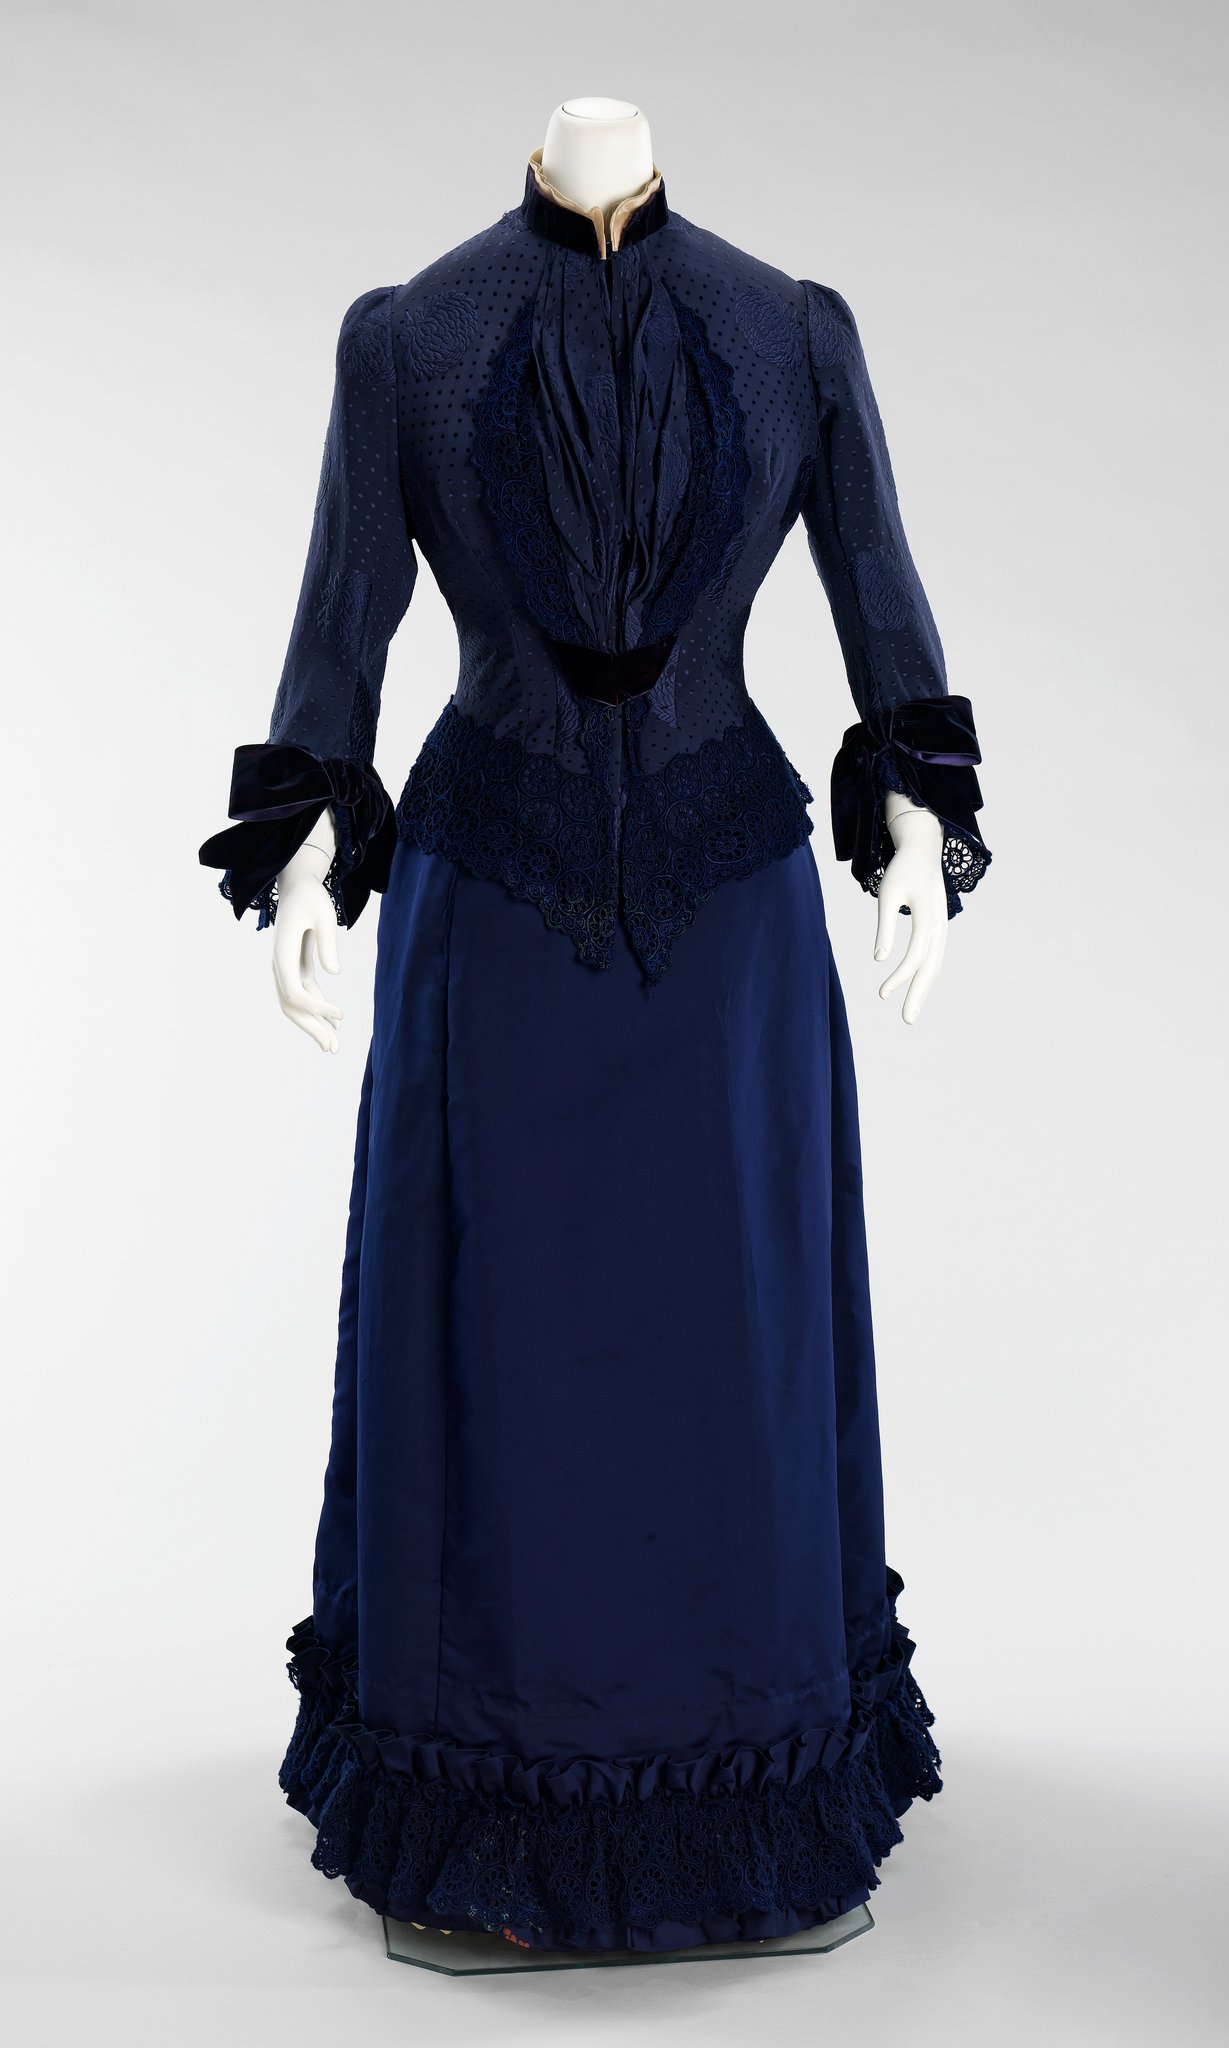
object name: dress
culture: french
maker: maison pingat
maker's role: design house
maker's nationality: french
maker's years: 1860-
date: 1885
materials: cotton, silk